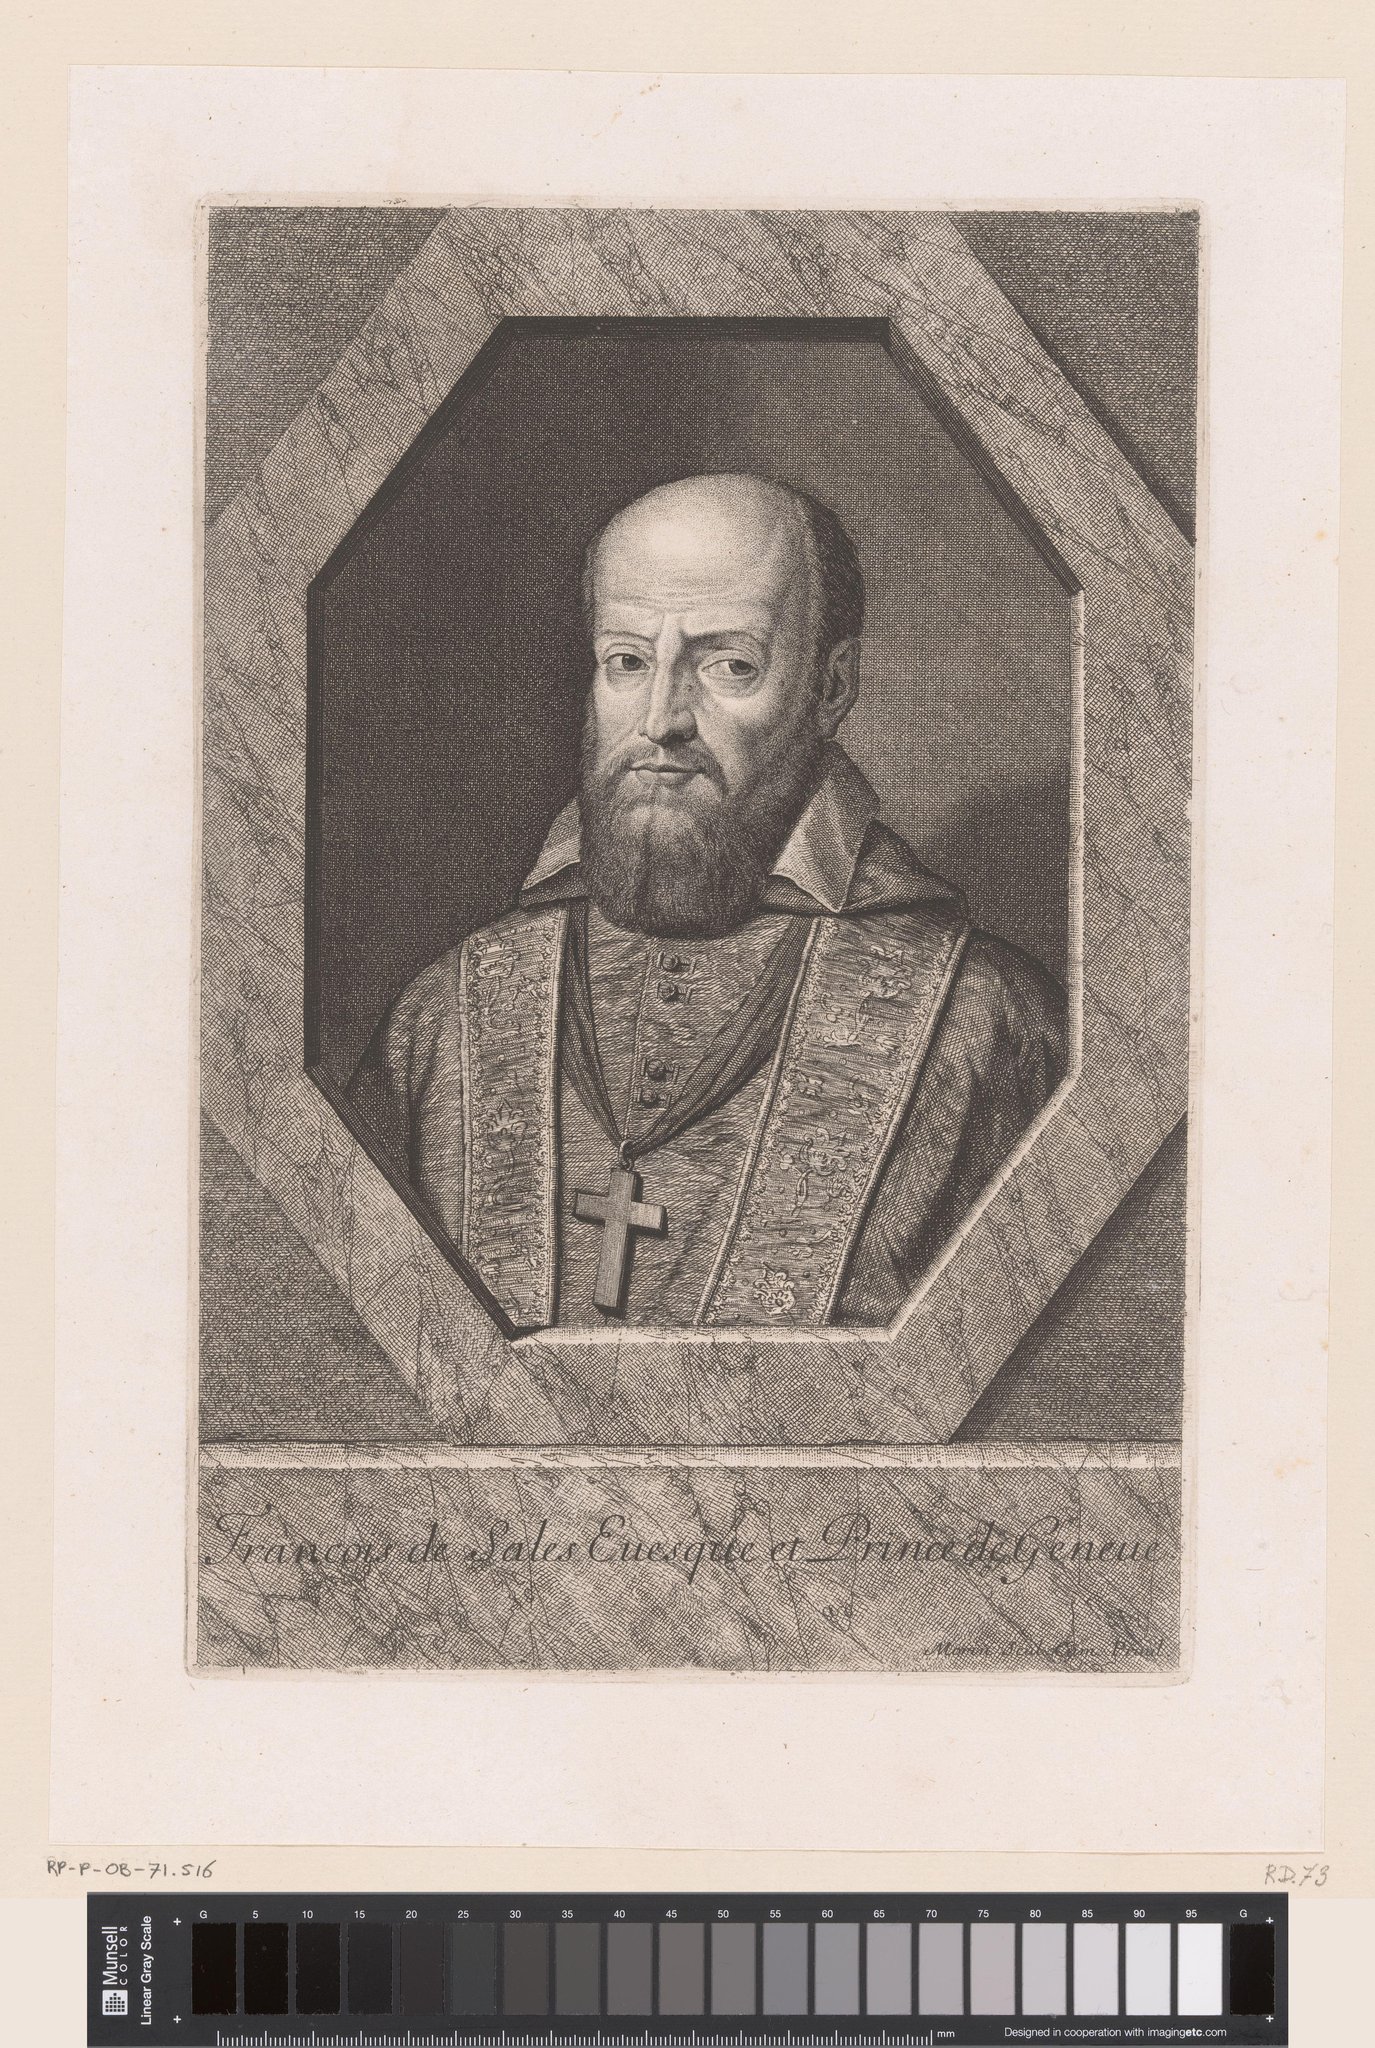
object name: print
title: Portret van Franciscus van Sales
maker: jean morin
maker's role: print maker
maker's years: 1605-1650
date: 1640-1650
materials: paper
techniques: etching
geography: france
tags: clergyman, historical persons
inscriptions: collector's mark: Lugt 2228